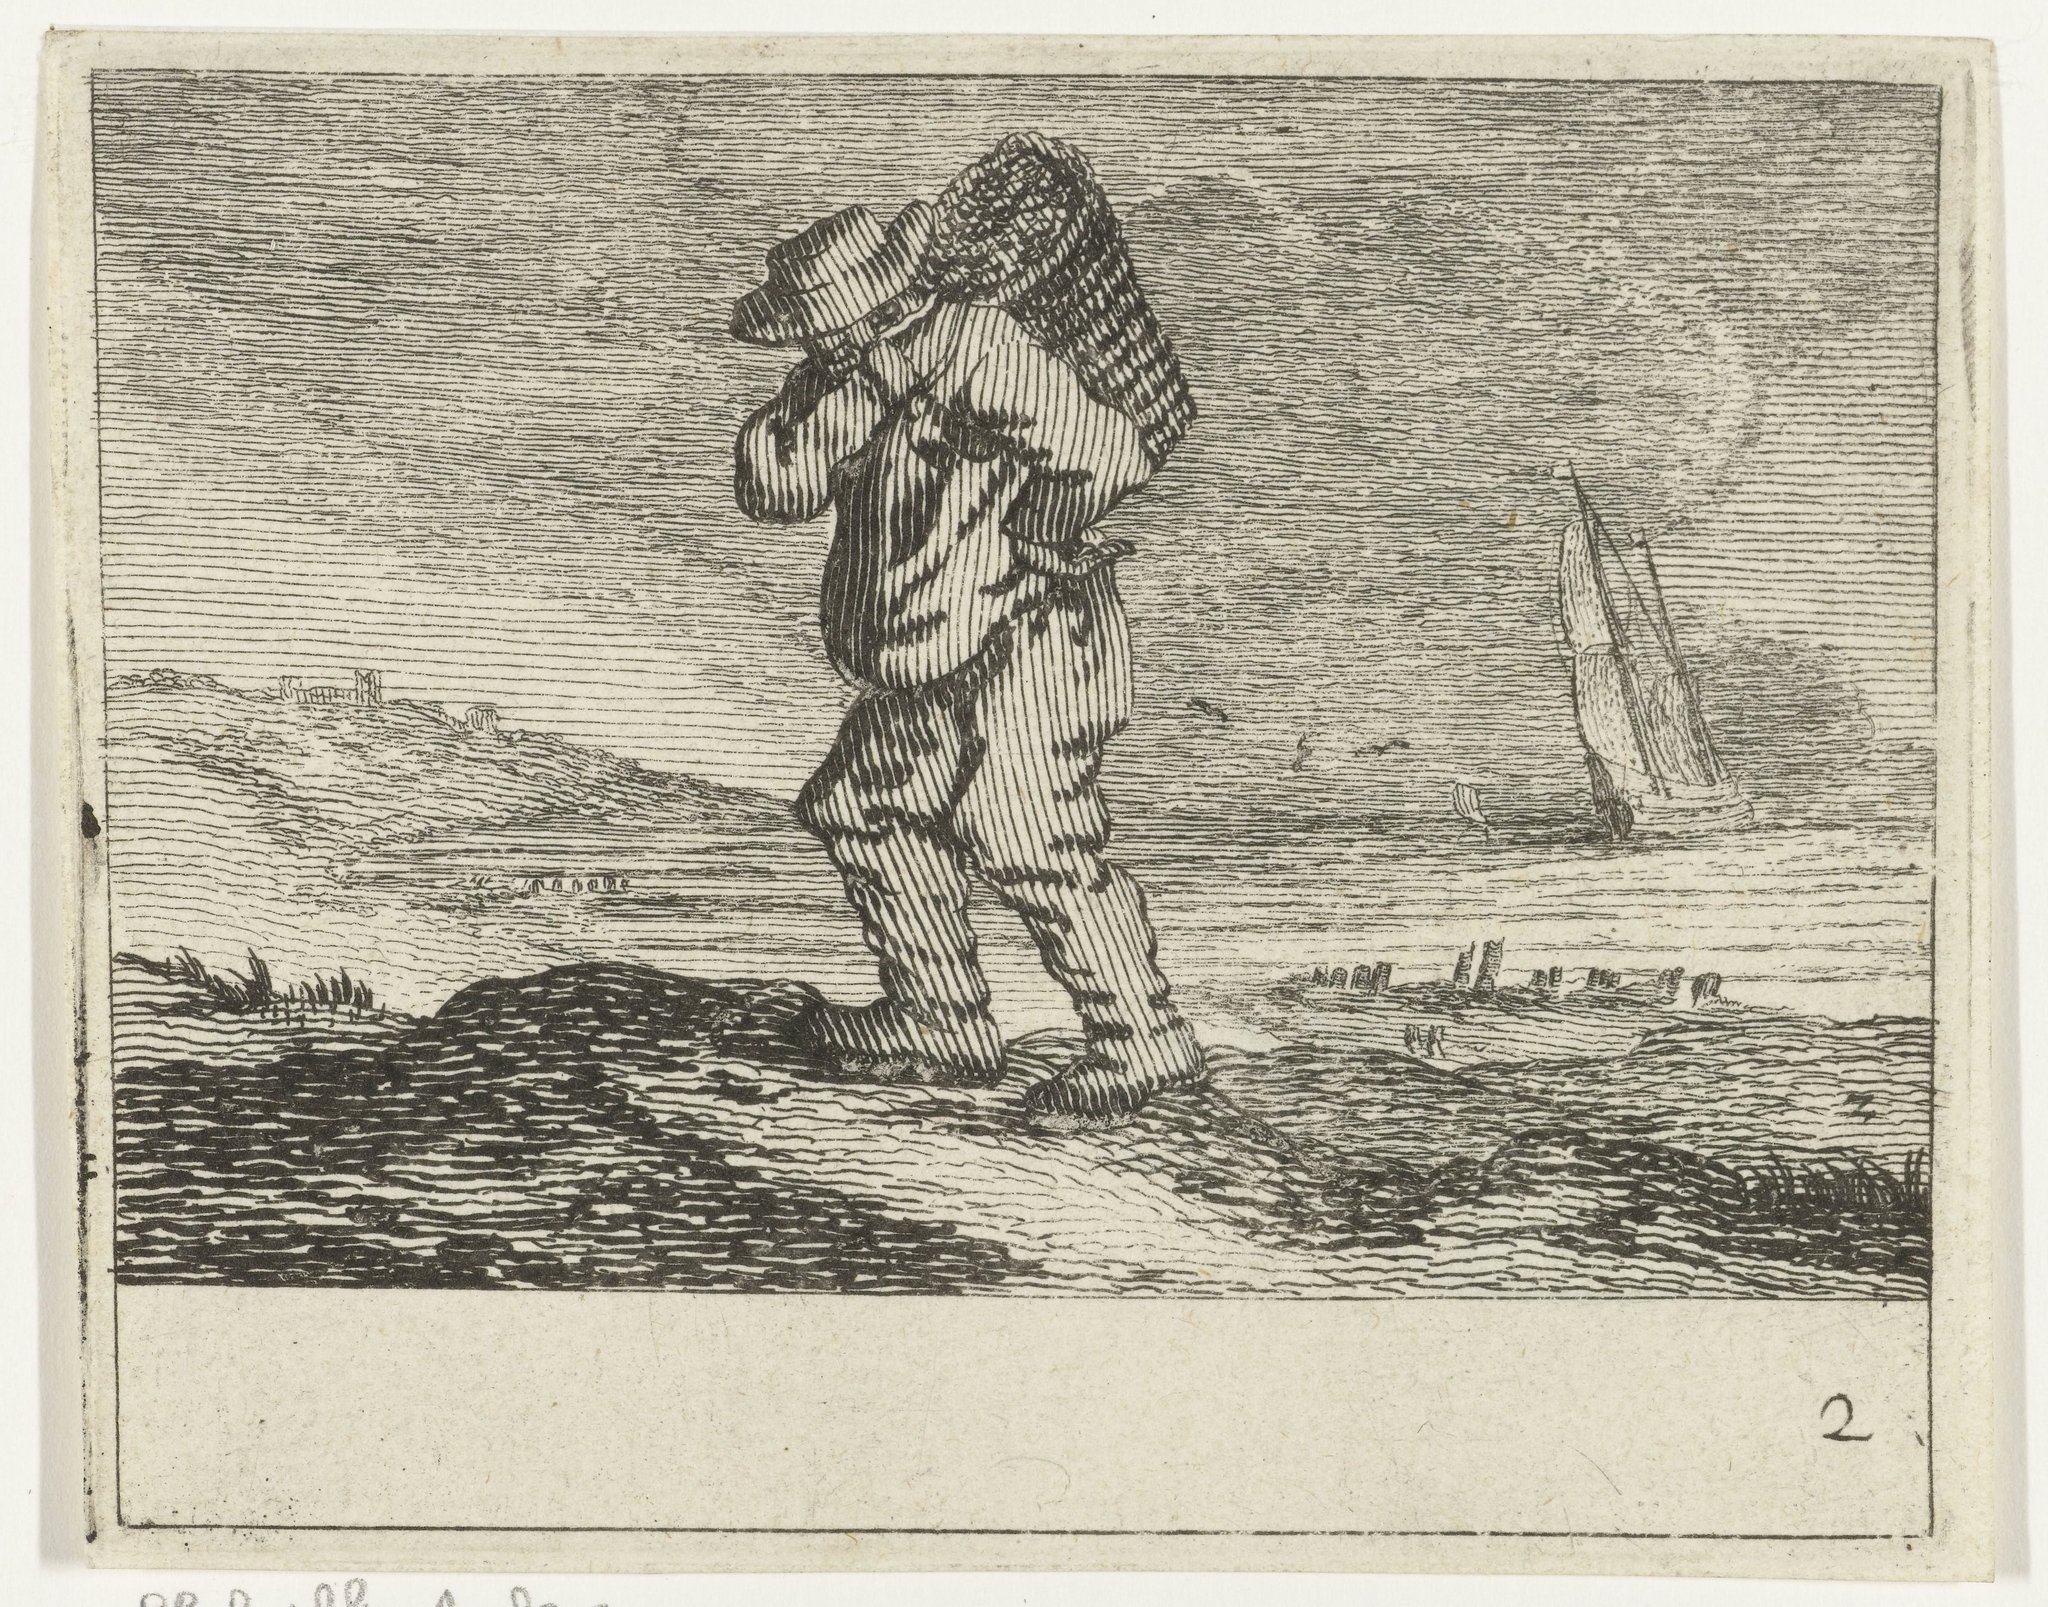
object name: print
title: Duinlandschap met een visser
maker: gillis van scheyndel (i)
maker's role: draughtsman, print maker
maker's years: 1595-1660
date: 1645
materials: paper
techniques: etching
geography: northern netherlands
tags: dune coast, carrying something in basket, bag, rucksack, etc., fisherman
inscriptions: collector's mark: Lugt 2228